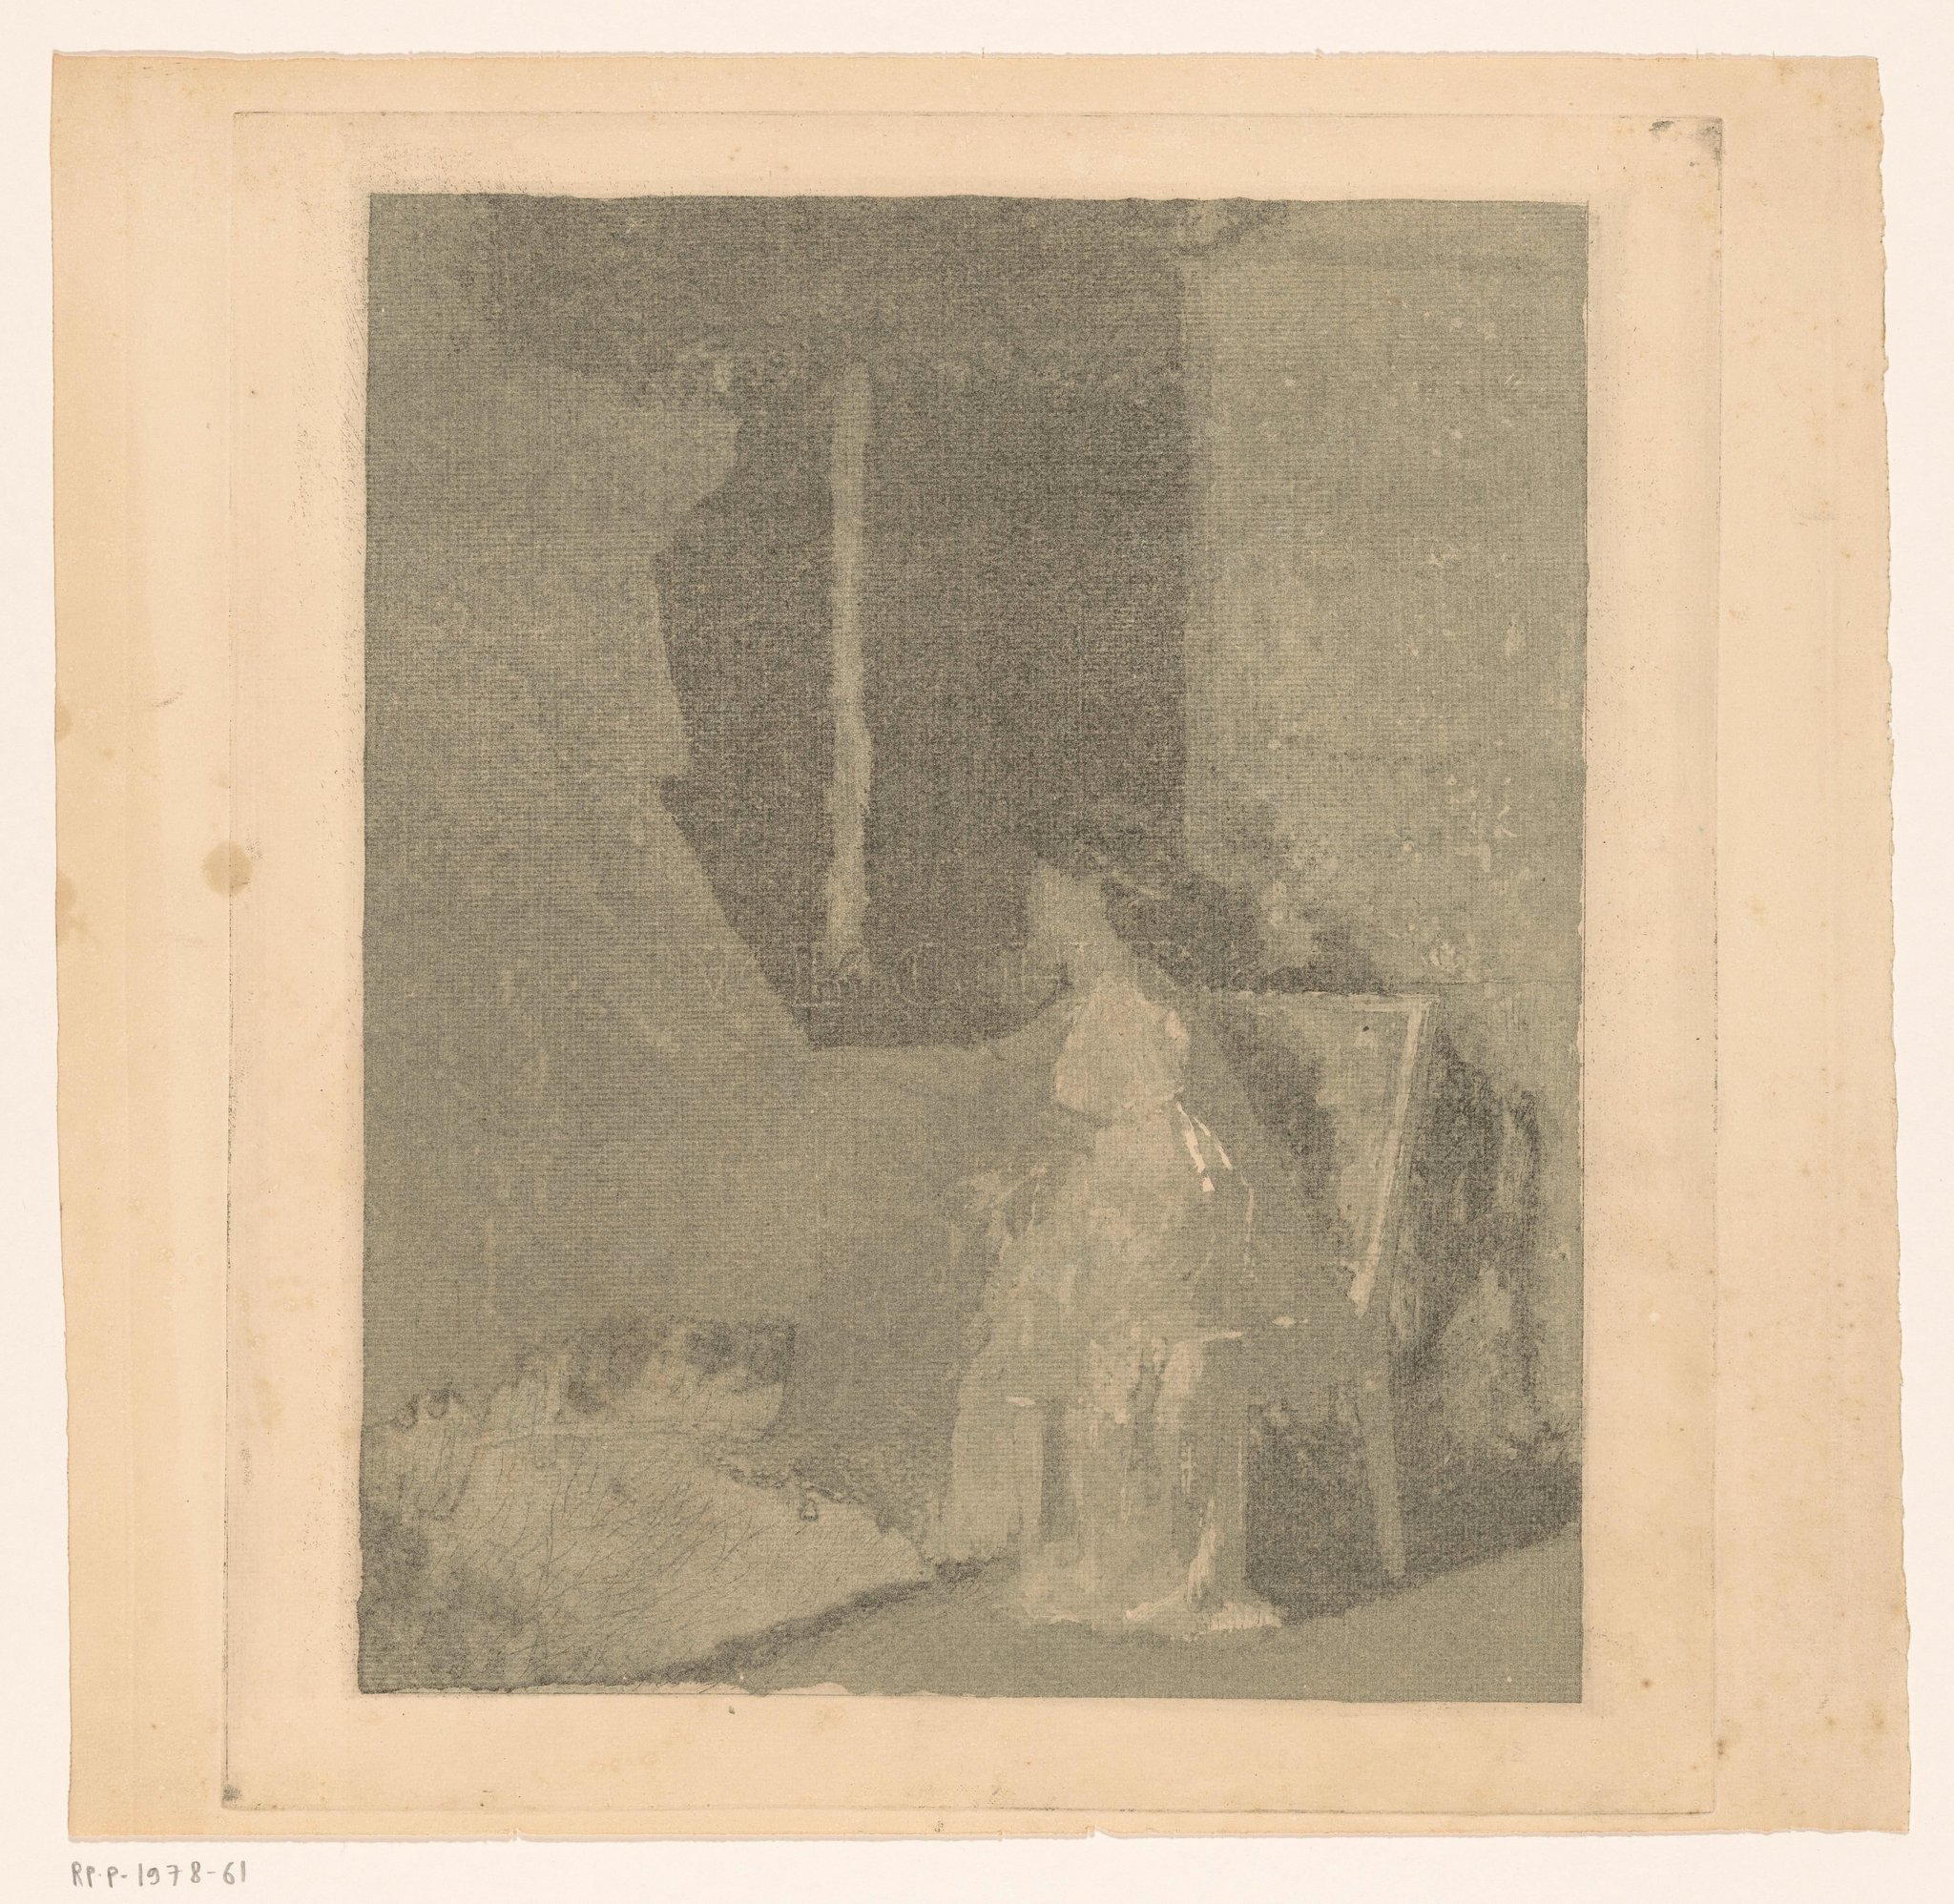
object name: print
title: Vrouw die op een stoel naast een wieg zit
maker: albert roelofs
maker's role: print maker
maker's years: 1877-1920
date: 1887-1920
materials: paper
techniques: monotype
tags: cradle, crib, mother and child(ren), woman and child(ren) (family group)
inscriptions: number: ‘1219 / 21’, collector's mark: Lugt 2228, collector's mark: Lugt 2760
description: De vrouw leunt met haar arm op de rand van de wieg.